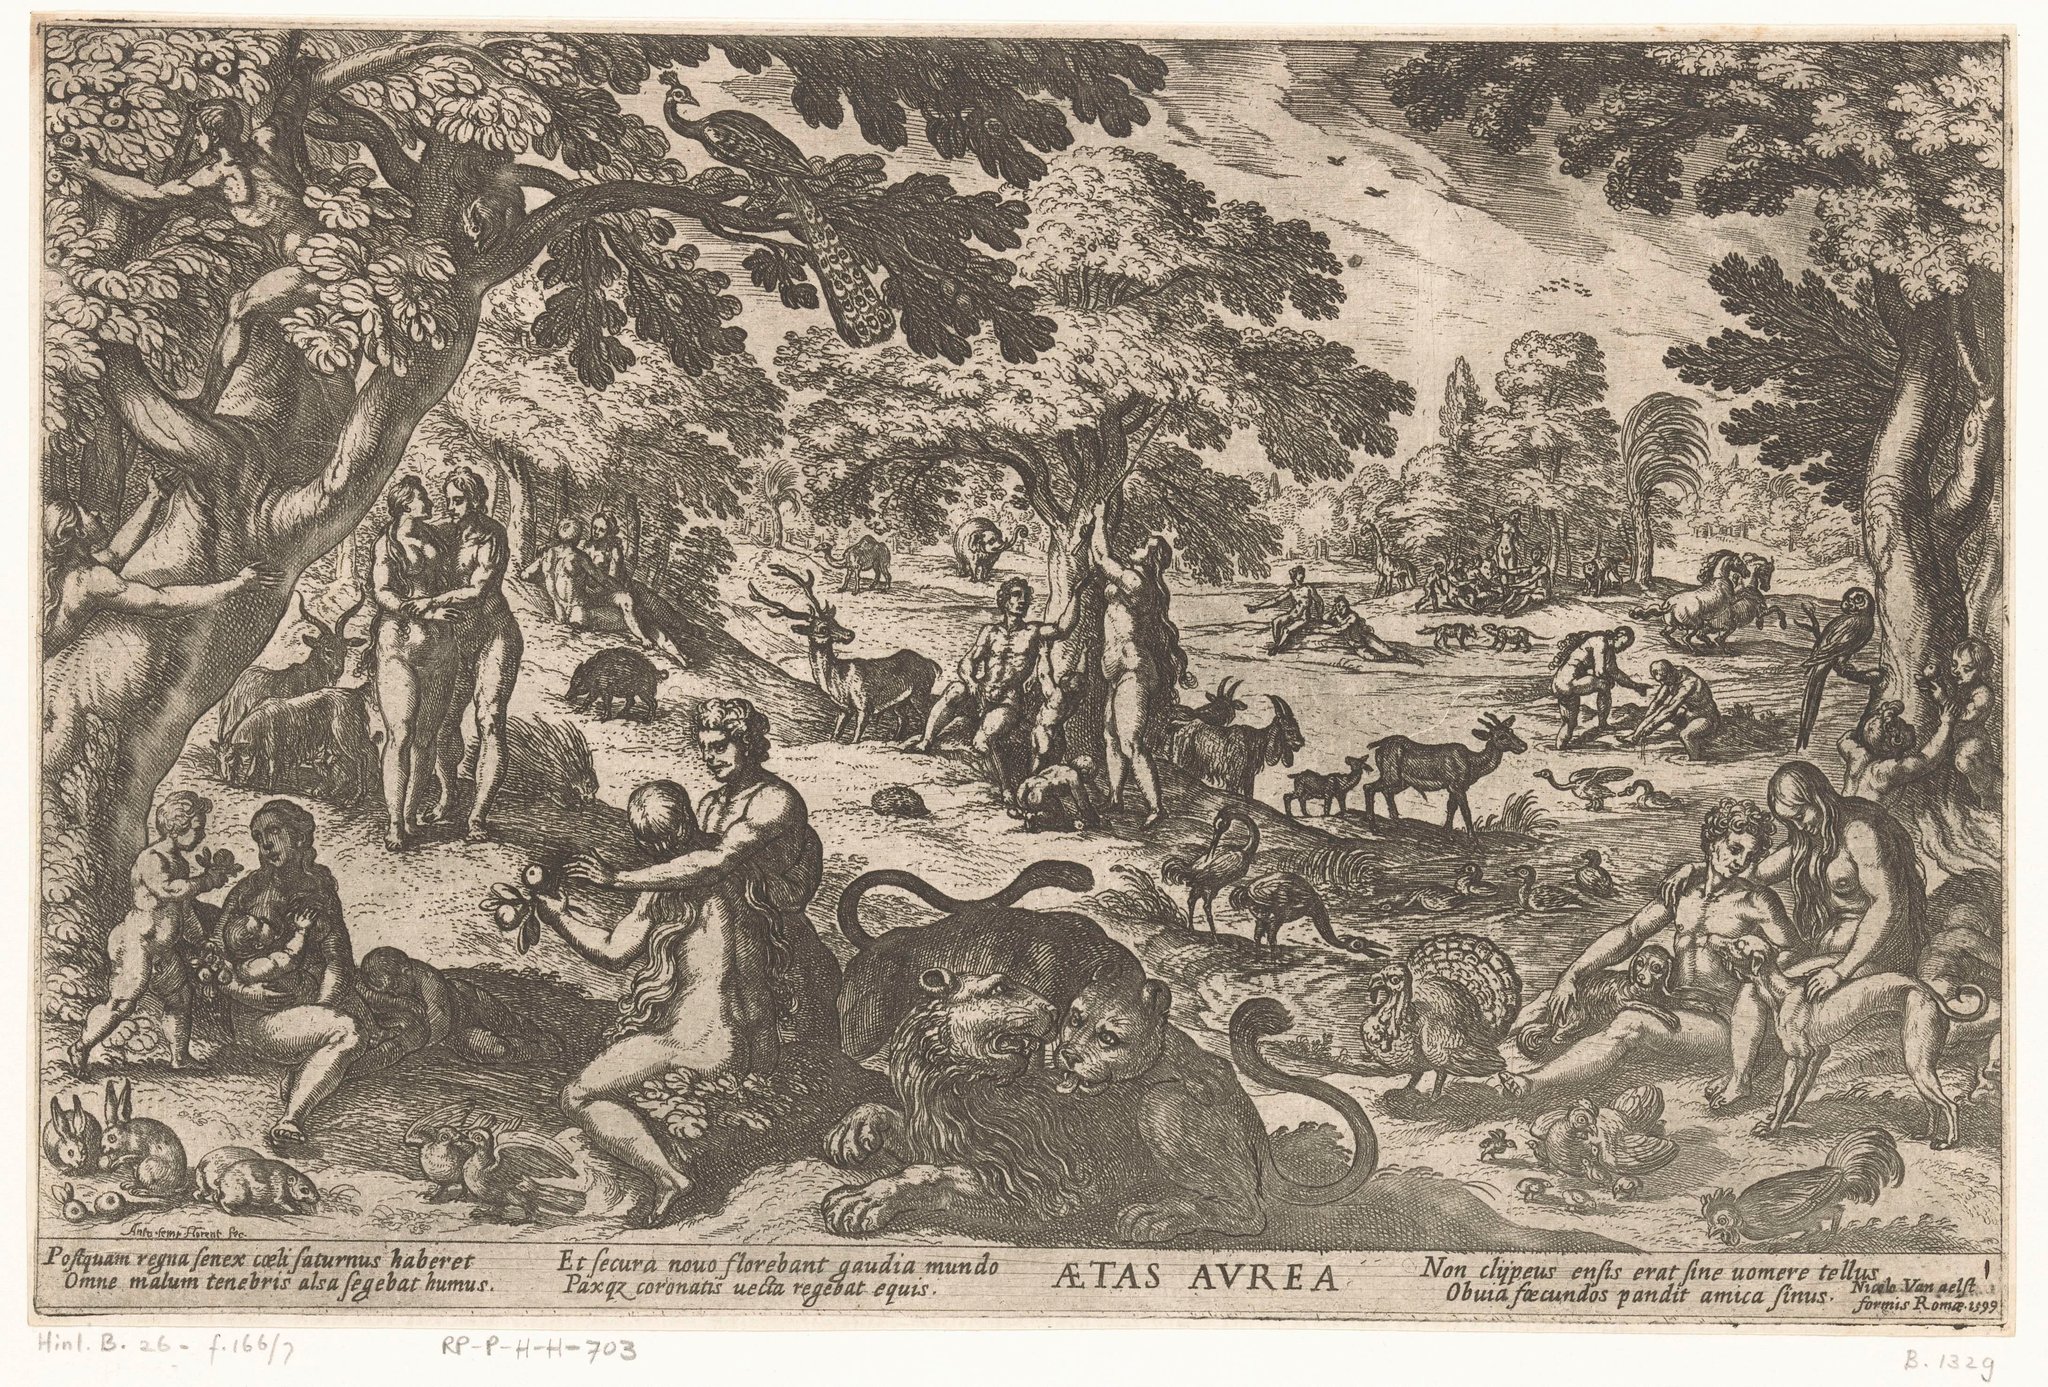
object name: print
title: Vier tijdperken van de wereld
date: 1599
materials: paper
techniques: etching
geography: italy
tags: the golden age, 'aetas aurea'; men live happily, gathering fruits under the reign of saturn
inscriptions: collector's mark: ‘Hinloopen’, number: ‘1’, collector's mark: Lugt 11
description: Het gouden tijdperk: mensen en dieren leven gelukkig in een paradijselijk landschap. Onderschrift en titel in het Latijn in ondermarge.